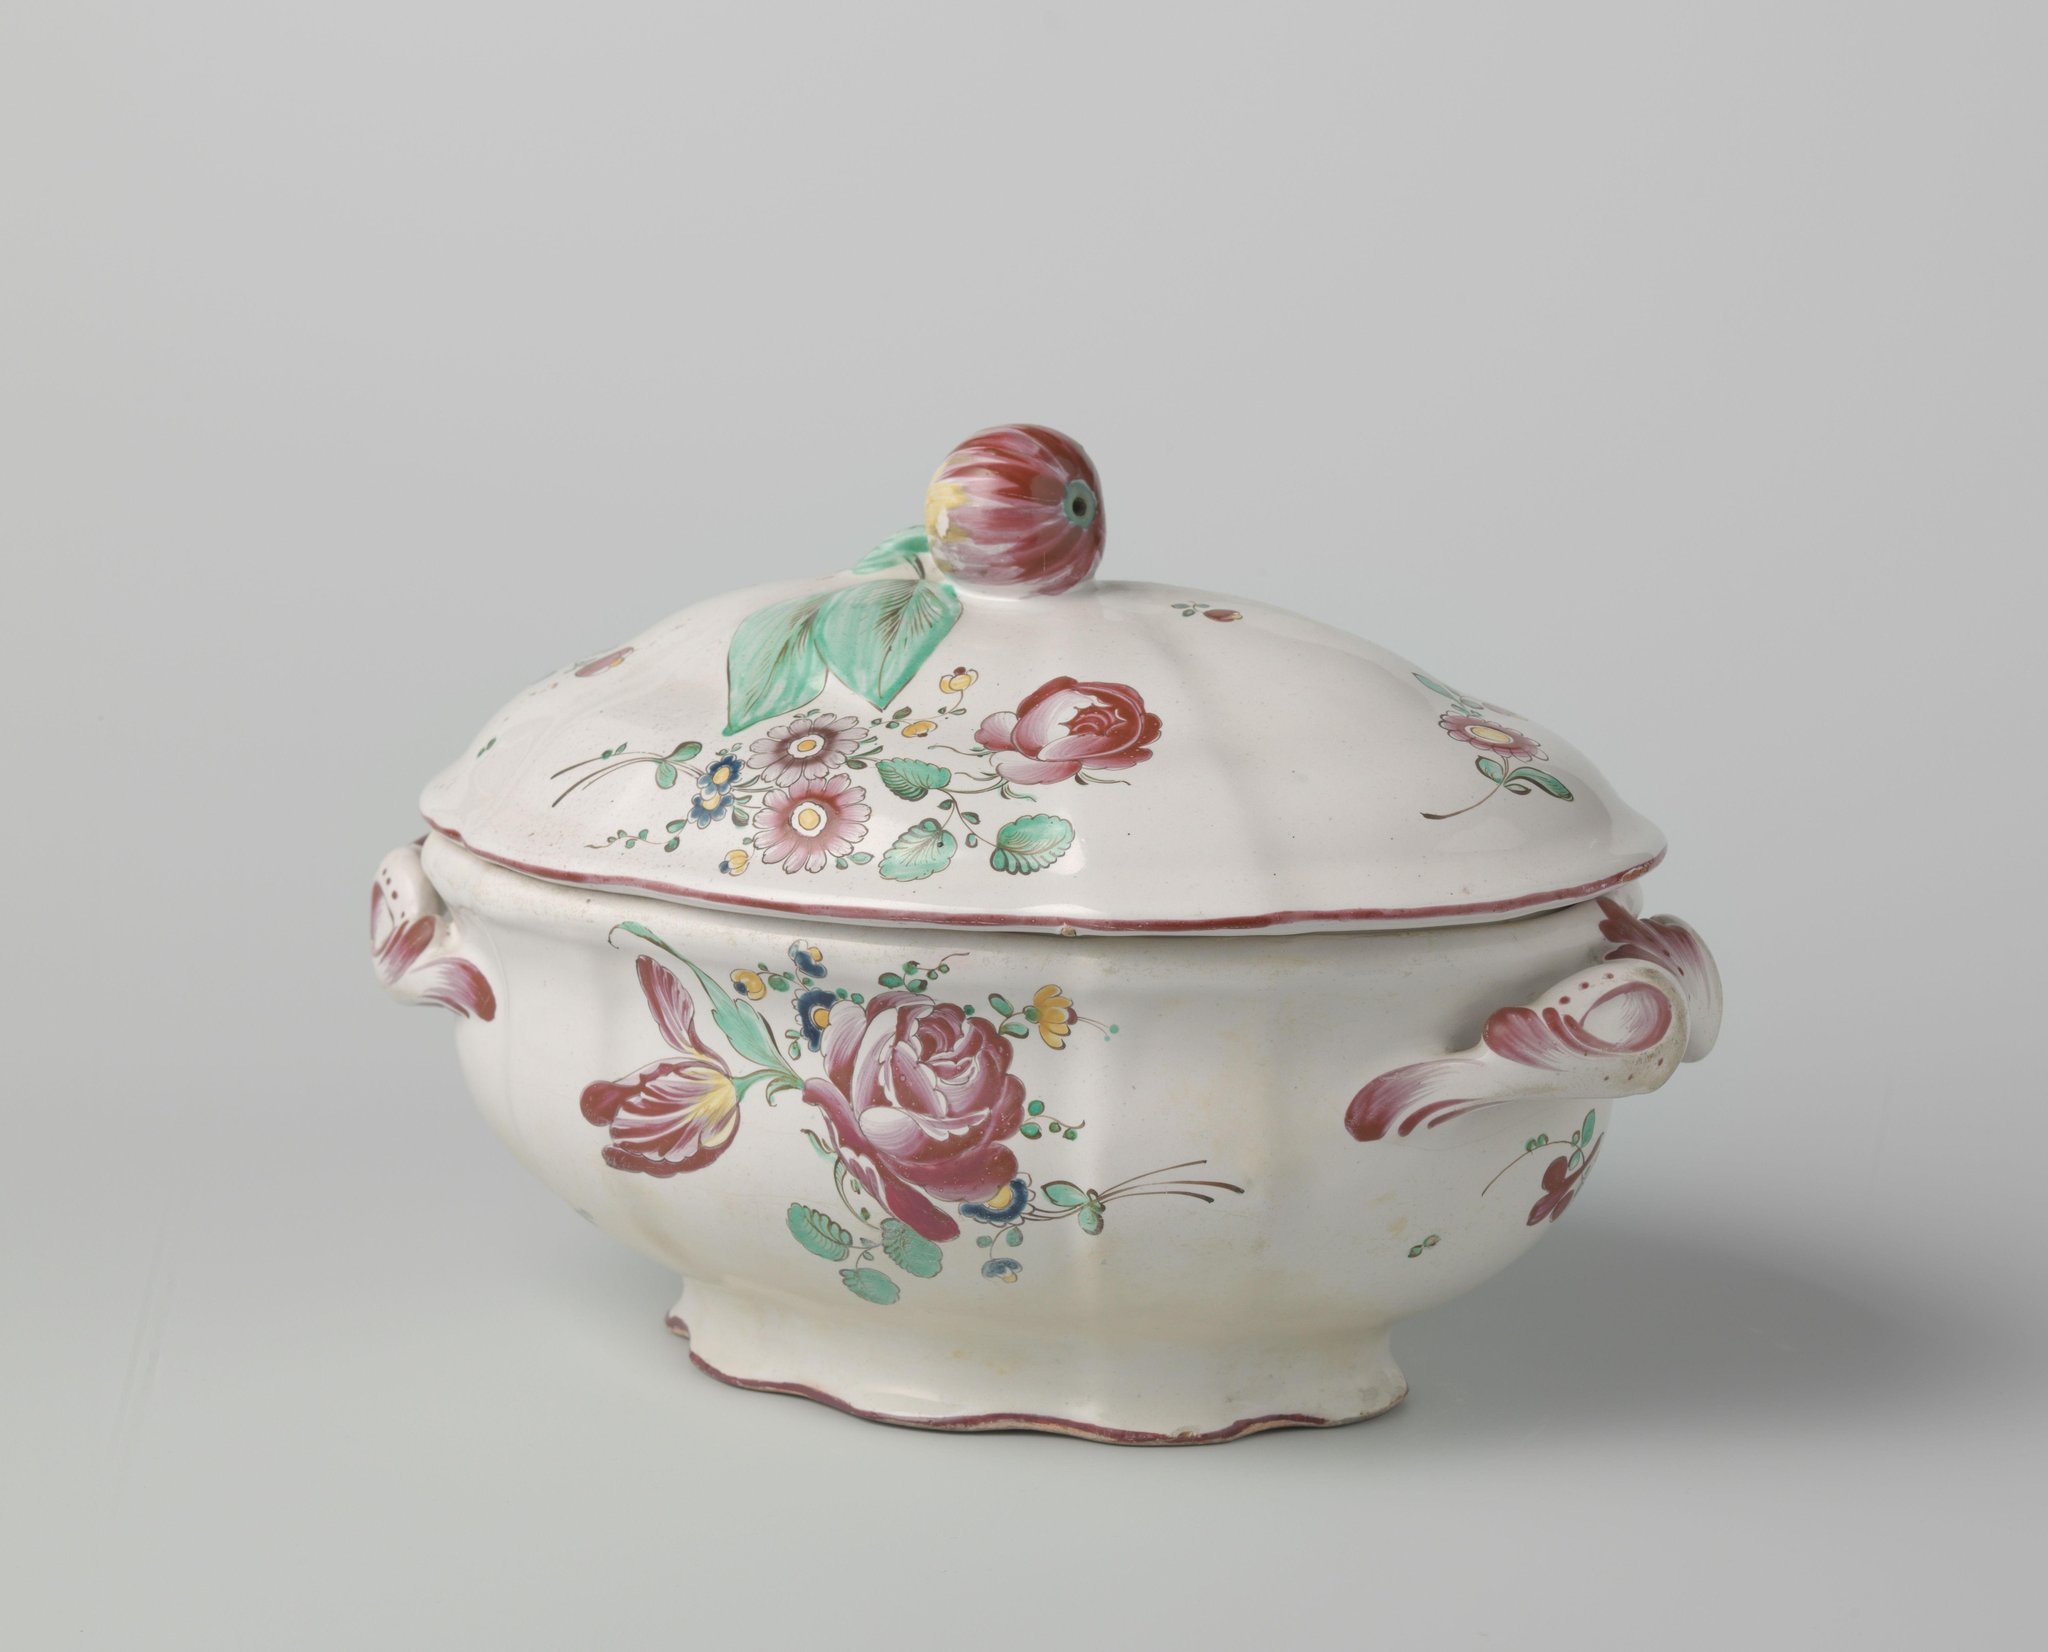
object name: soup tureen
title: Deksel van soepterrine van aardewerk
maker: Anonymous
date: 1740-1760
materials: earthenware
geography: straatsburg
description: Deksel van soepterrine van aardewerk. Het gewelfde en gegolfde deksel is versierd met twee bouquetten, waarvan één is samengesteld uit een paarse tulp, een paarse roos en een tak blauwe en gele bloemen en groene bladeren en de andere uit een roos, twee asters en een takje gele en blauwe bloemen. De deksel wordt bekroond door een paarse en gele vrucht aan een steel met lichtgroene bladeren. Het glazuur is enigszins kalkachtig. Geen merken.